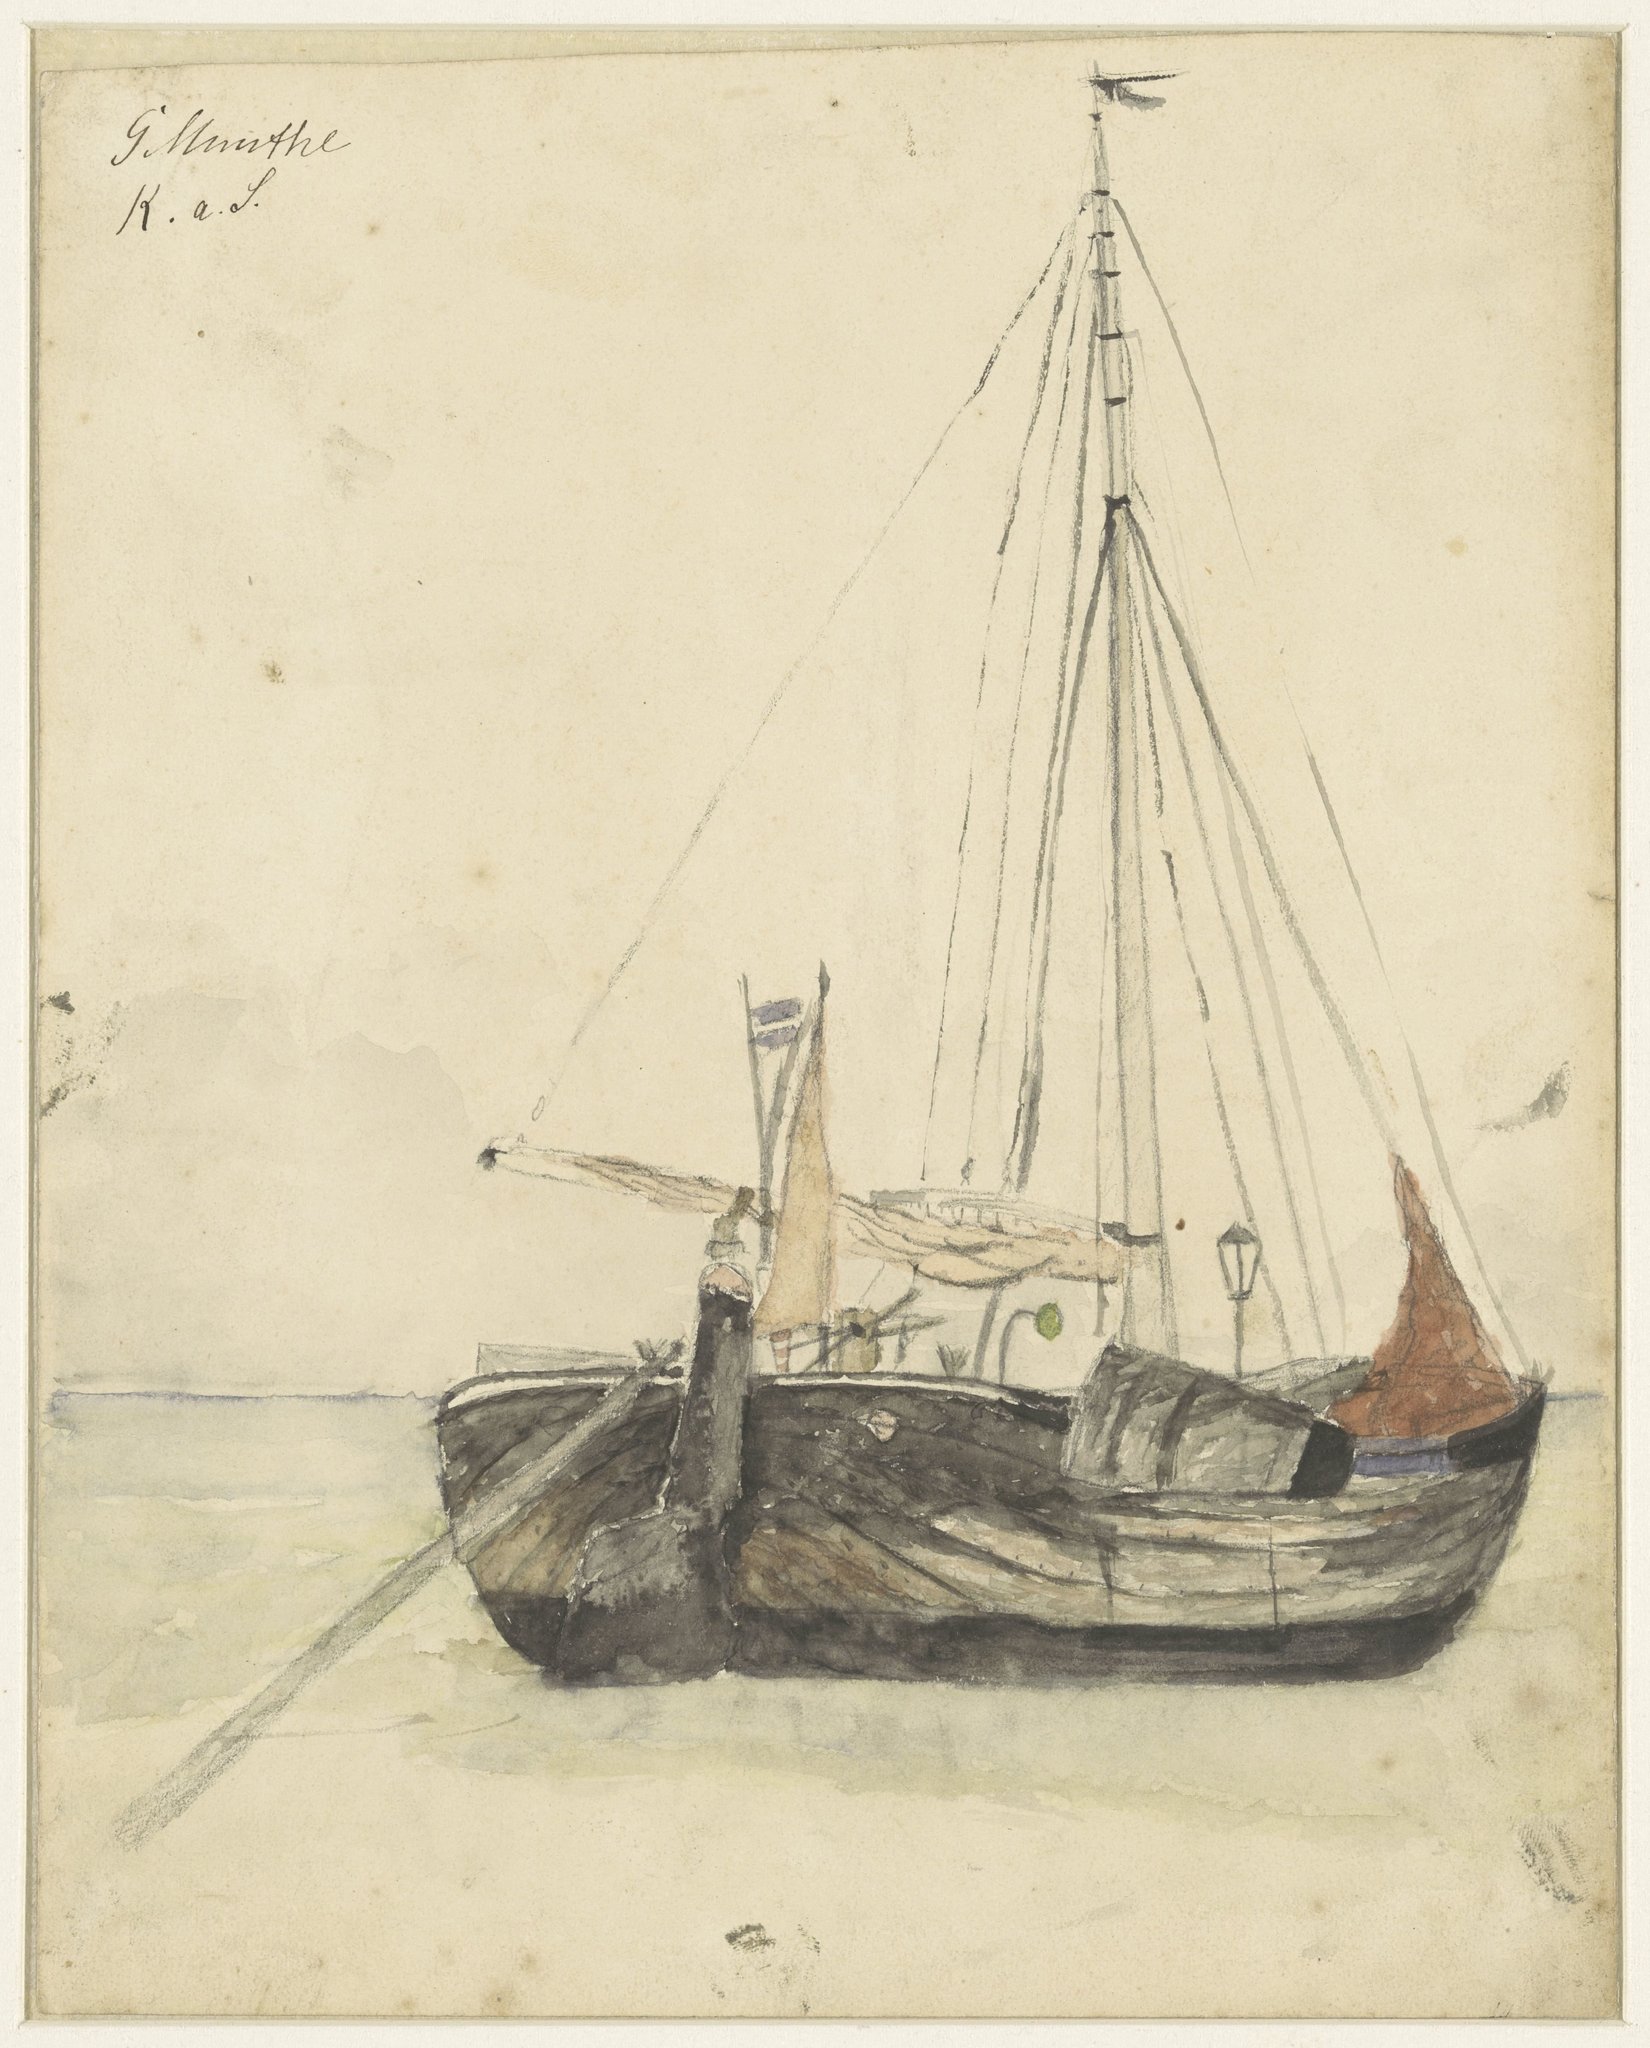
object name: drawing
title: Visserspink te Katwijk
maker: gerhard morgenstjerne munthe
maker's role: draughtsman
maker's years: 1875-1927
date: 1885-1927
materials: paper, pencil, watercolor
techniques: brush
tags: sailing-ship, sailing-boat, beach